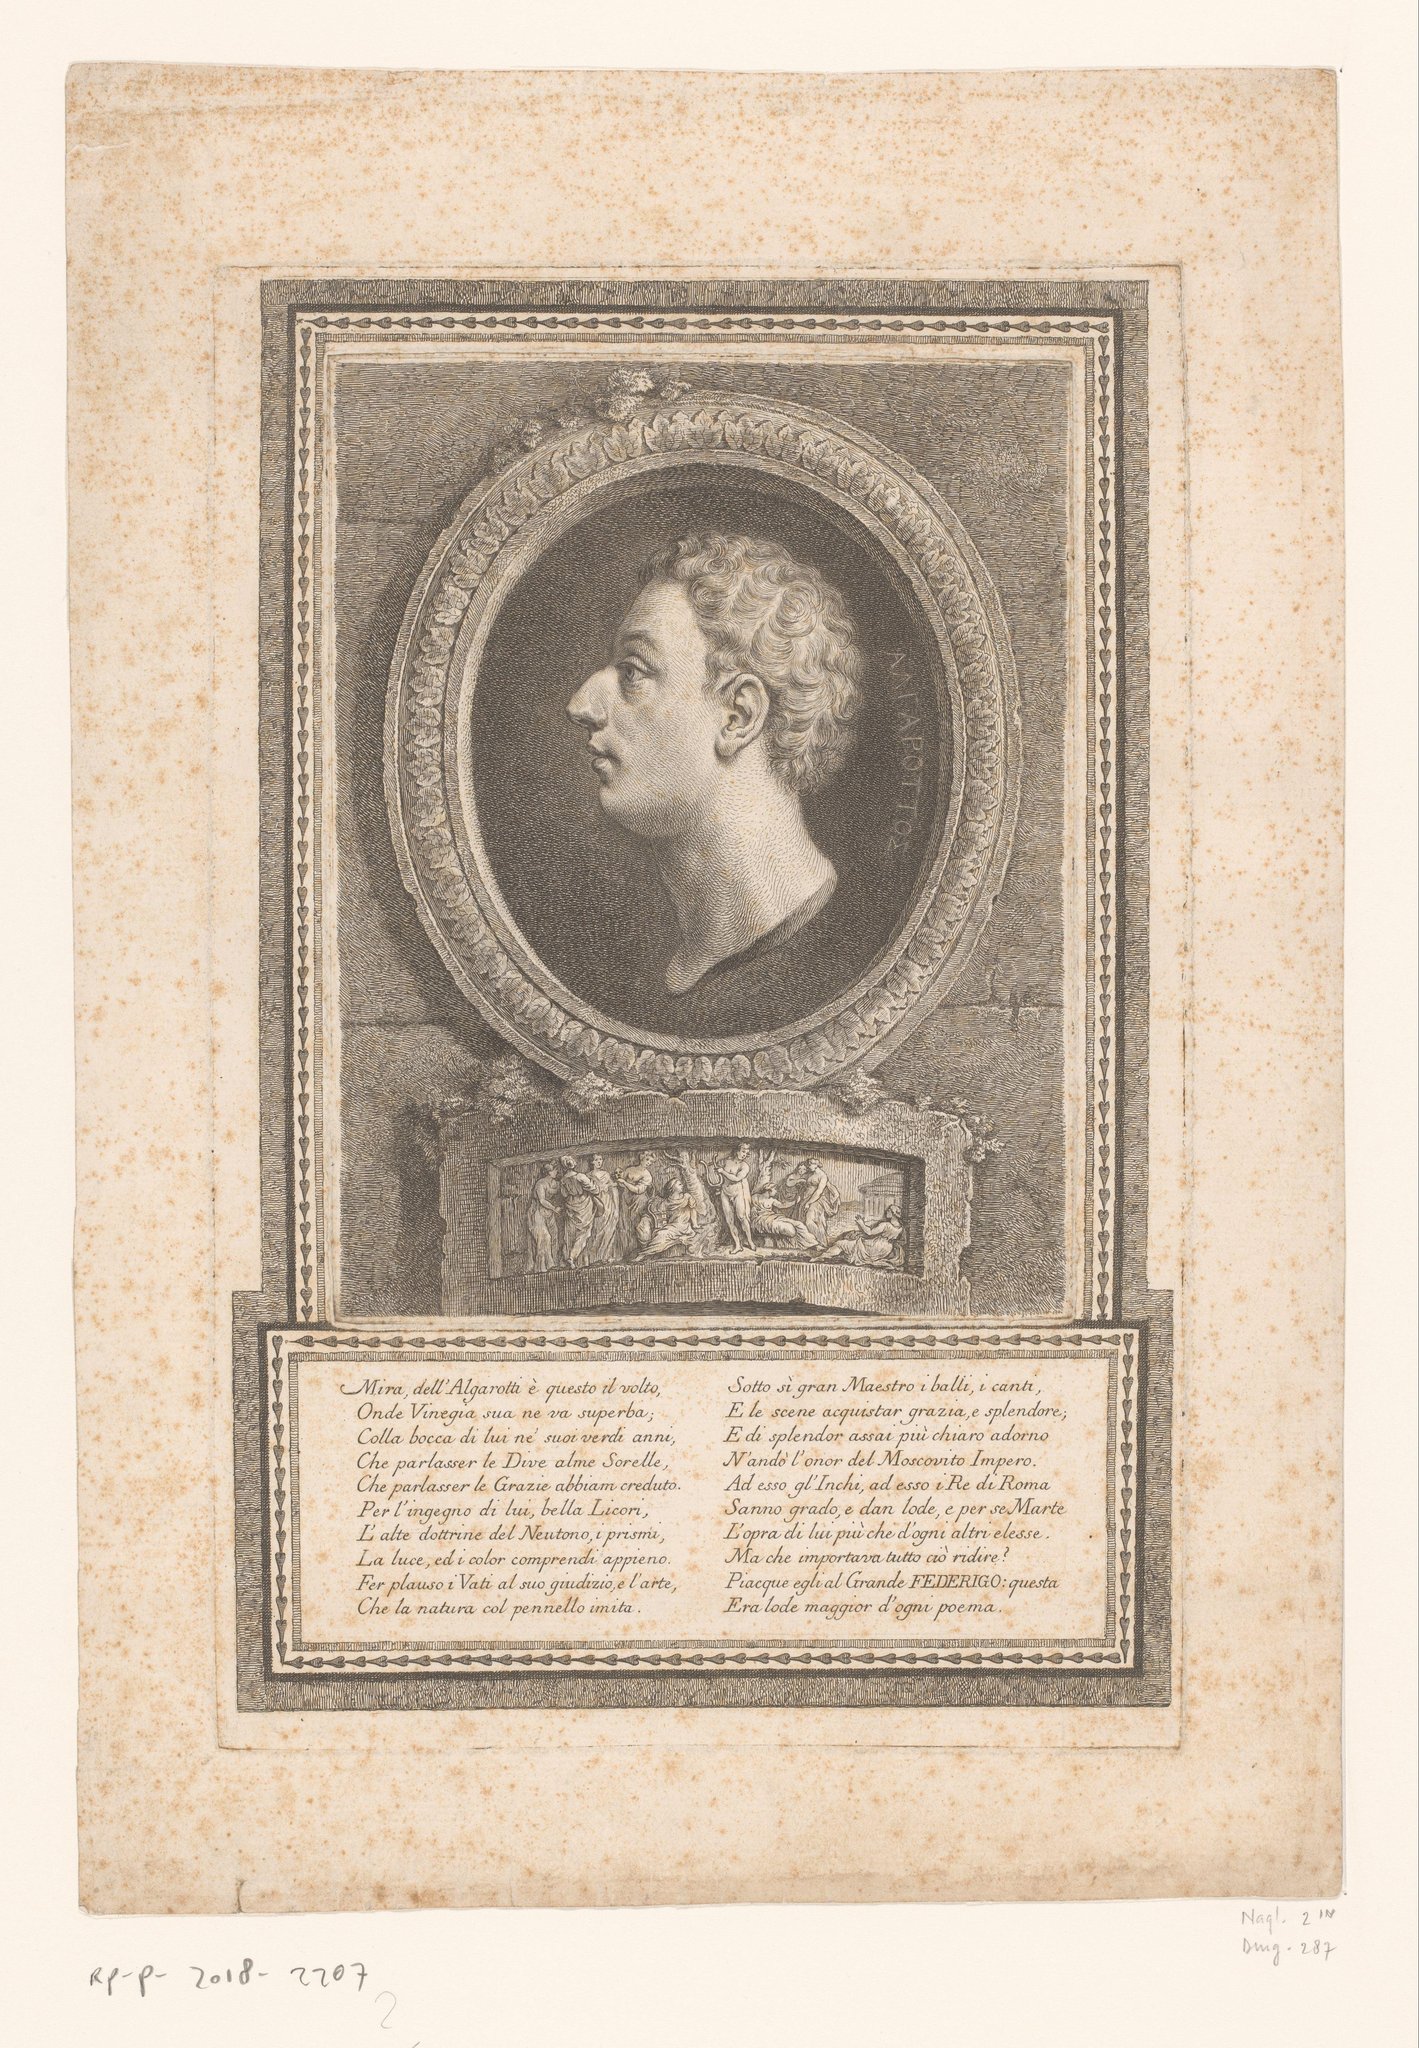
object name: print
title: Portret van Francesco Algarotti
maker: georg friedrich schmidt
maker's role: draughtsman, print maker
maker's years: 1712-1775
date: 1752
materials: paper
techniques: etching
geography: berlin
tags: venice, francesco algarotti, historical persons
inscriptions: collector's mark: Lugt 2228, collector's mark: Lugt 2760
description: Portret en kader met tekst gedrukt van twee platen.